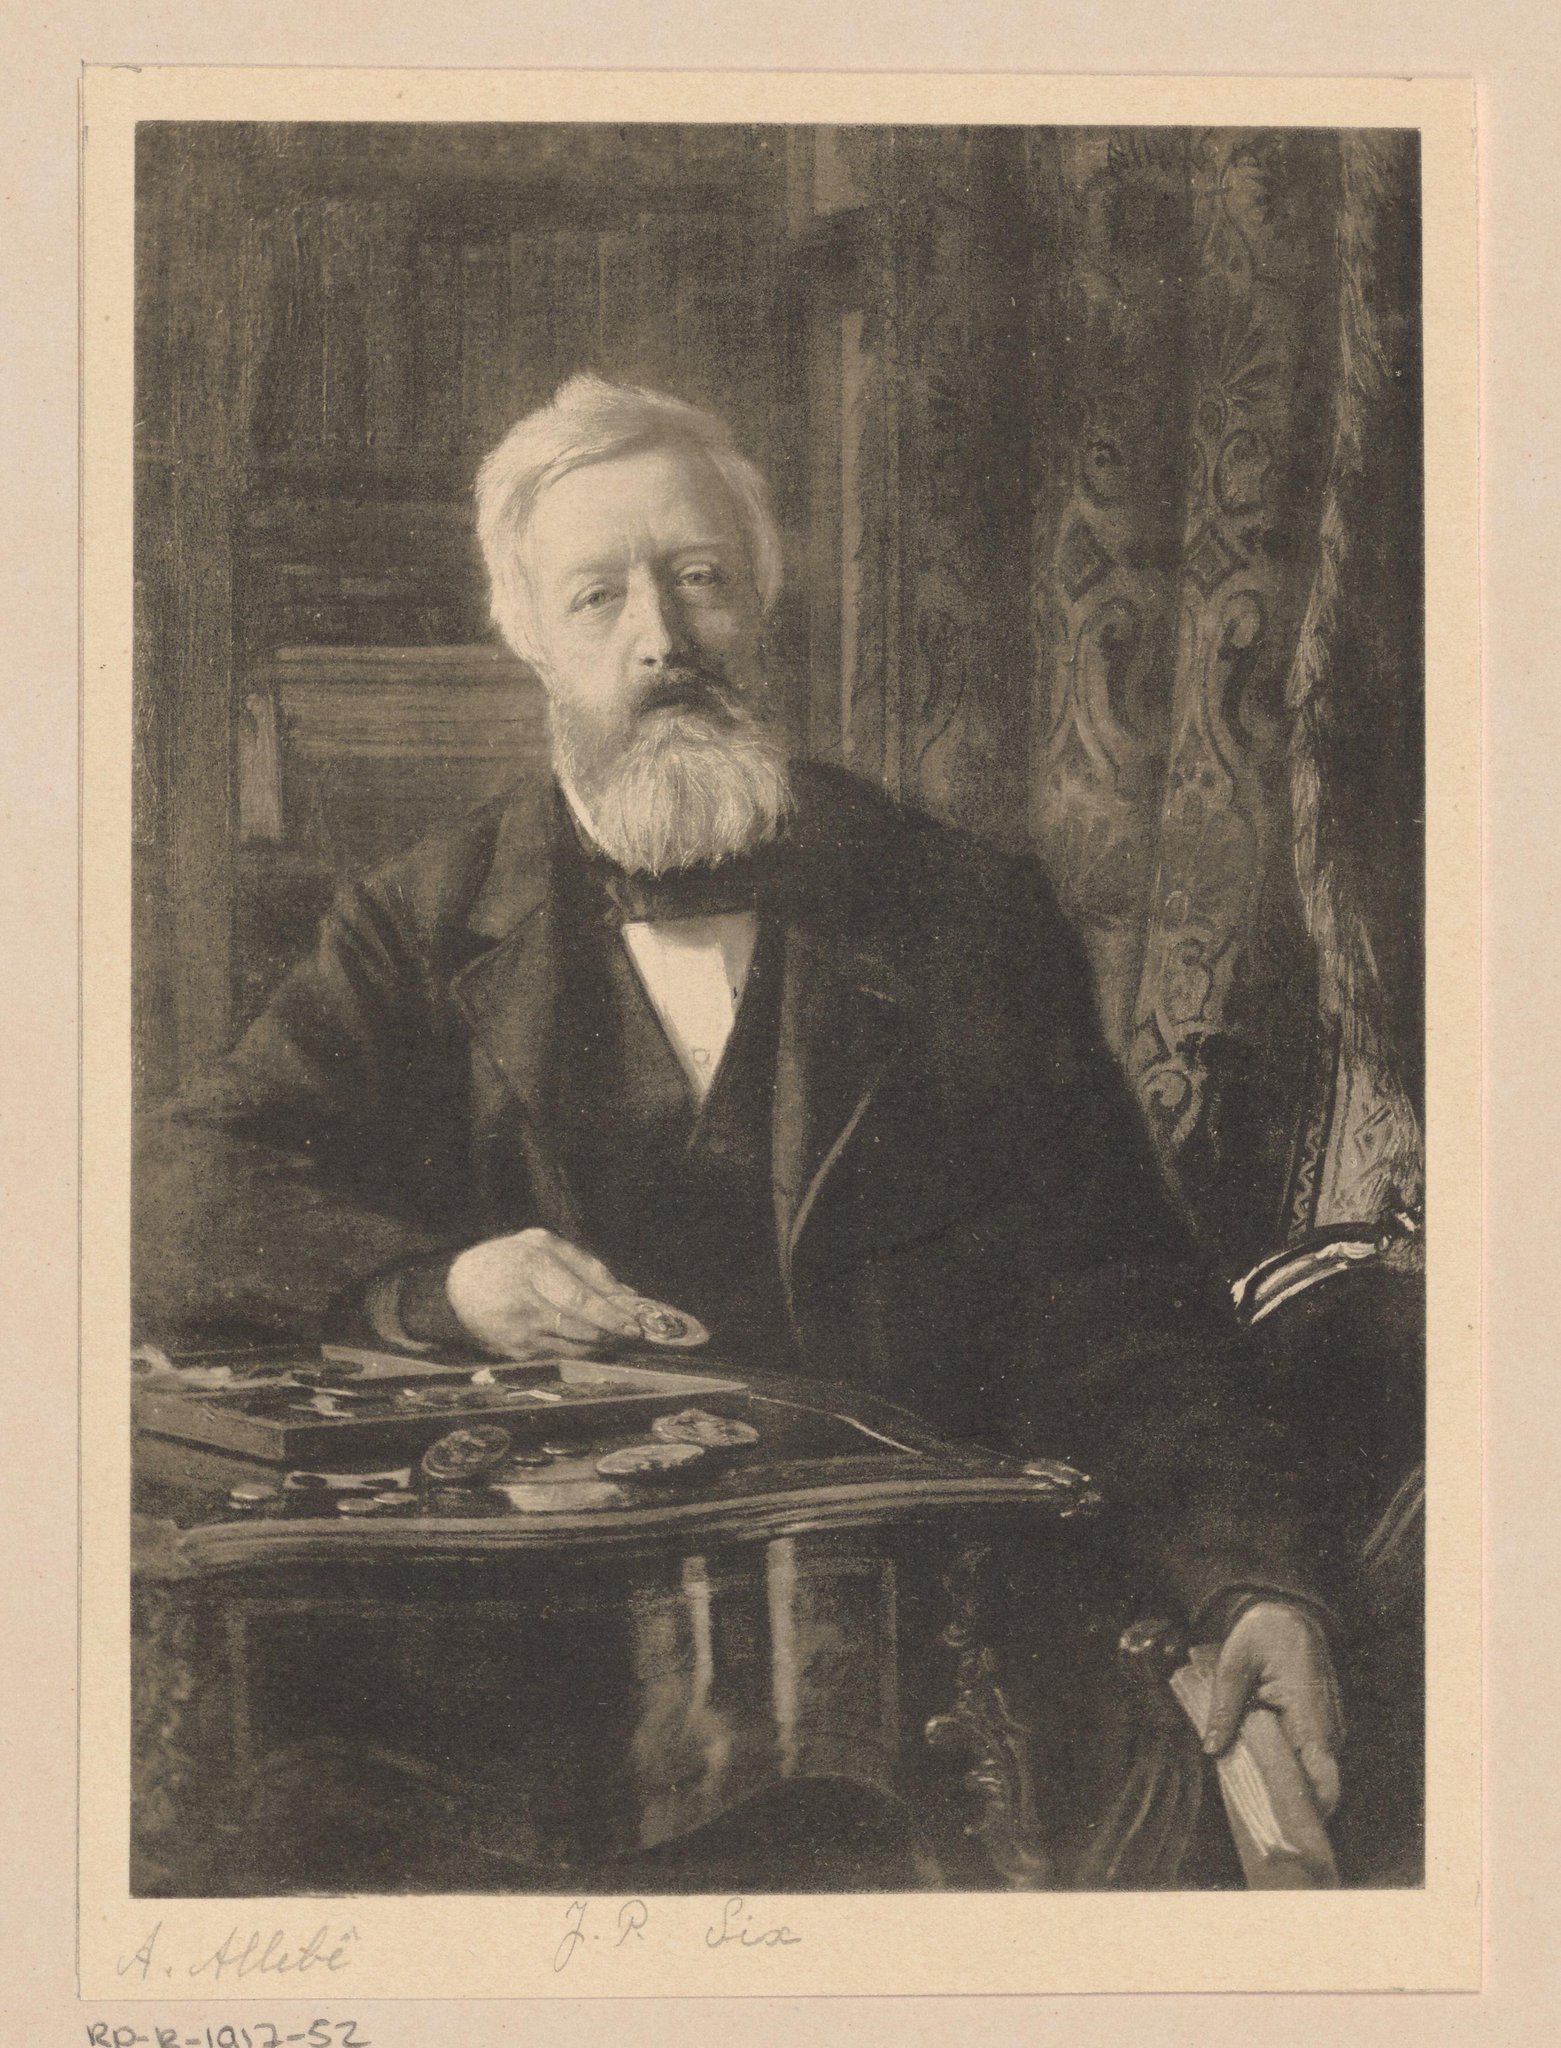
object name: photomechanical print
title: Portret van Jan Pieter Six van Hillegom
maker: Anonymous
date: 1882-1930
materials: paper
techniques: photograph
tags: amsterdam, draughtsman, historical persons, art collector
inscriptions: inscription: ‘A. Allebé J.P. Six’, collector's mark: Lugt 2228